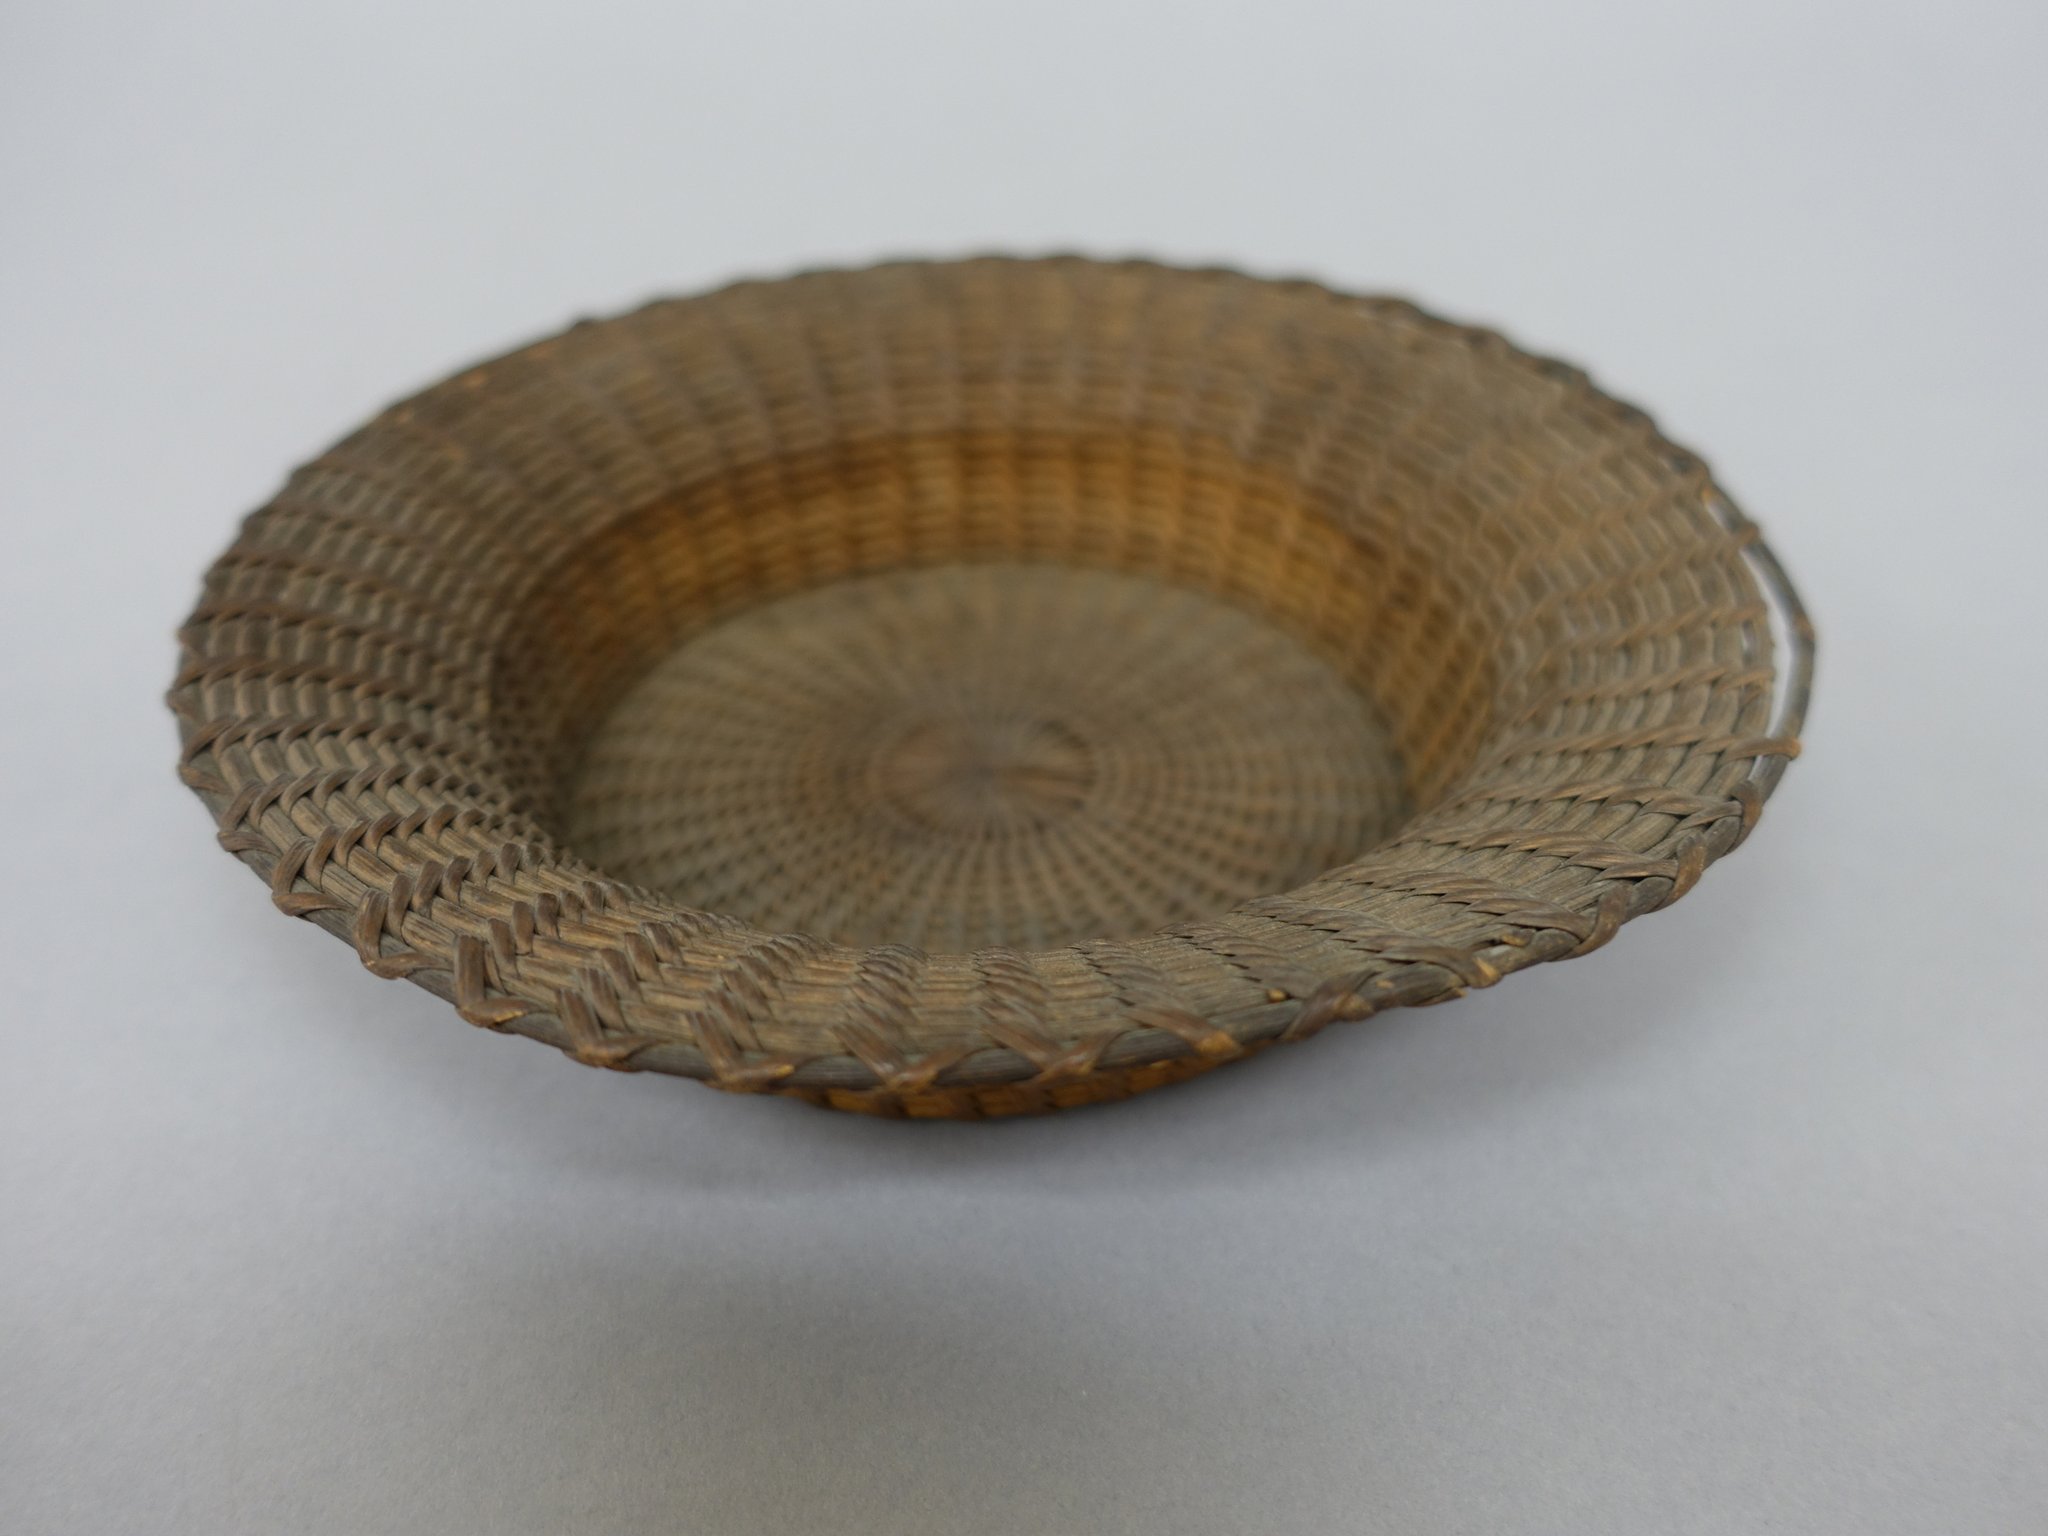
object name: basket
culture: japanese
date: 1801-1900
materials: bamboo